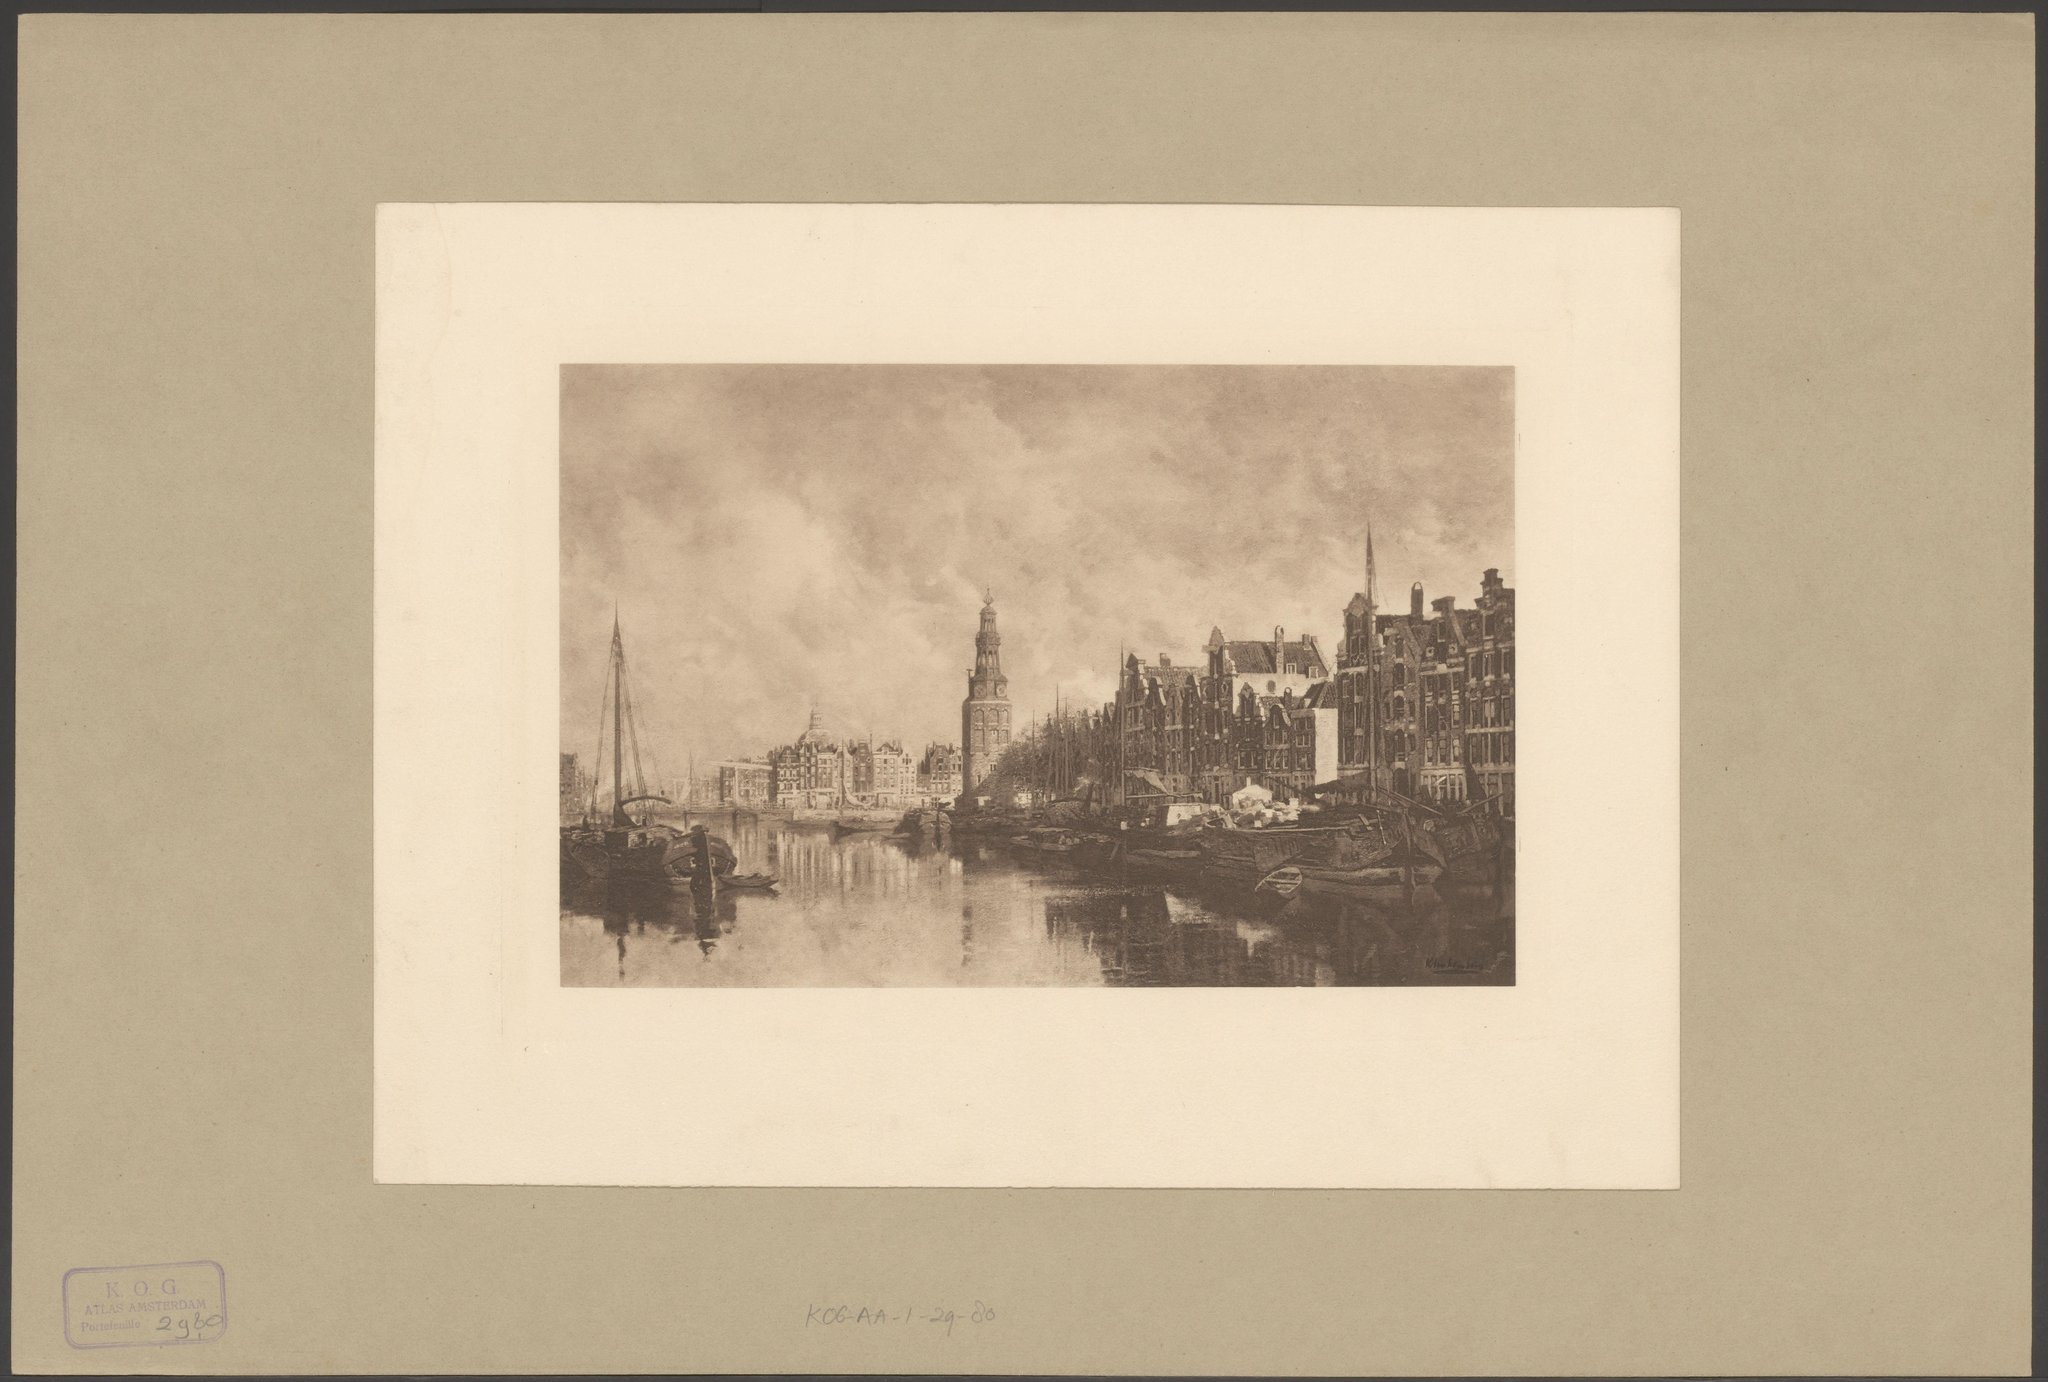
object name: photomechanical print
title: Gezicht op de Montelbaanstoren te Amsterdam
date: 1896-1915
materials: paper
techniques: photoaquatint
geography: netherlands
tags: tower, clock tower ~ monumental adornment, traffic on the water, canals, waters (in city) (+ city(-scape) with figures, staffage)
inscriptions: collector's mark: Lugt 1641b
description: Onderwerpsrubriek binnen de Atlas Amsterdam: Montelbaanstoren.